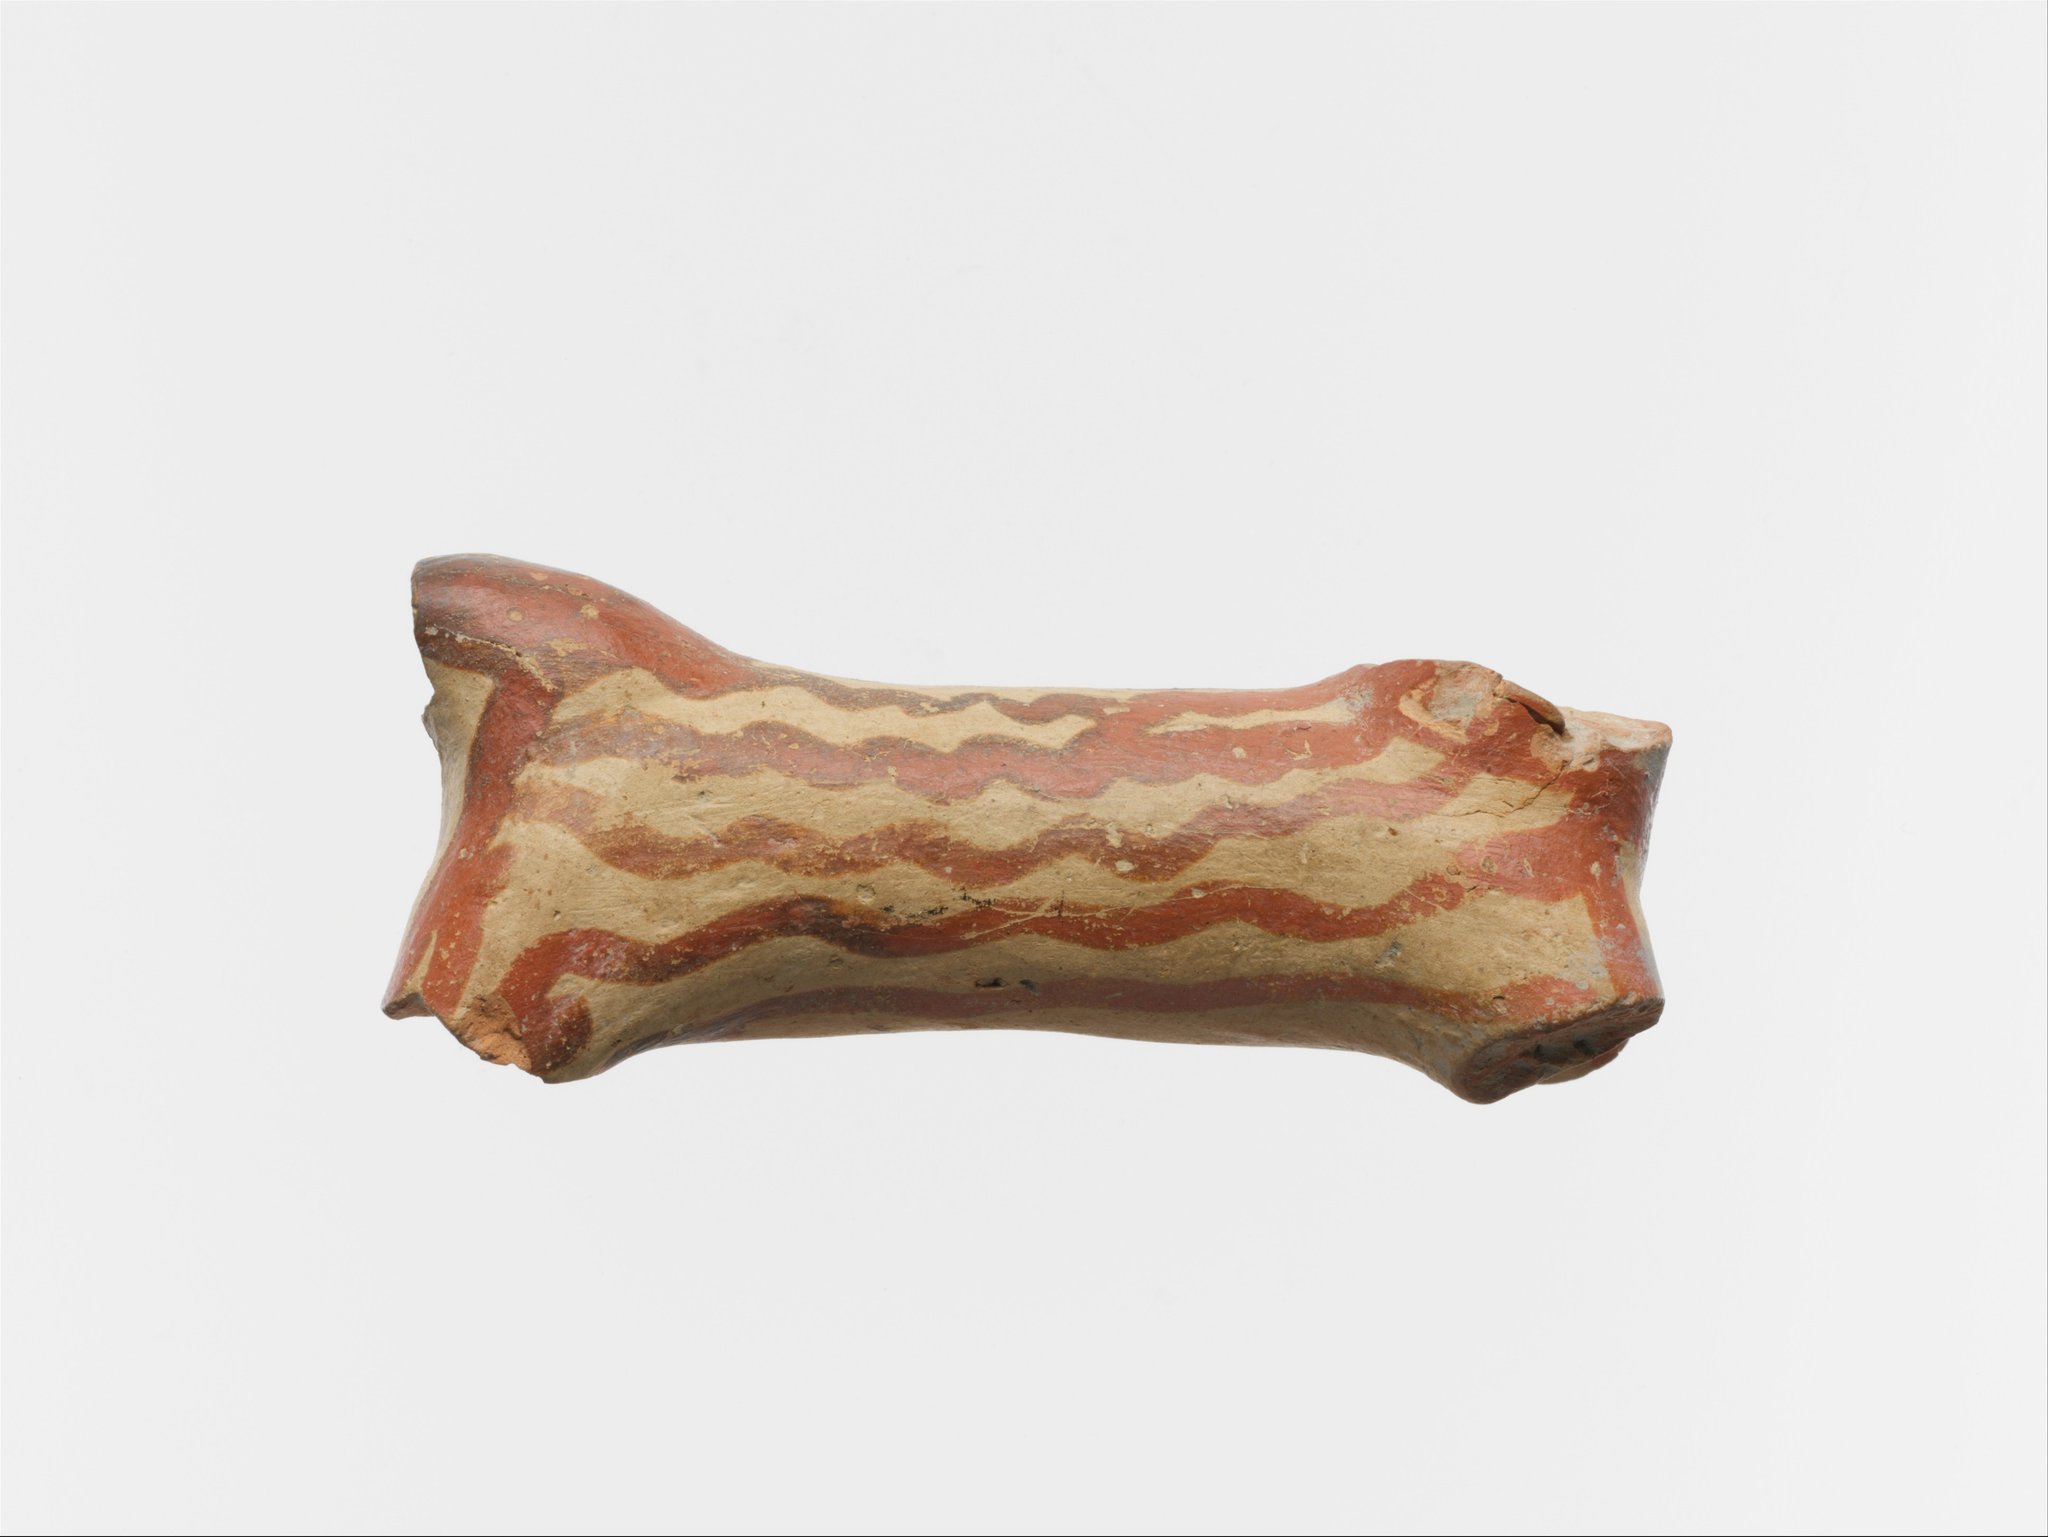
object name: statuette of a cow and calf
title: Terracotta animal figurine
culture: mycenaean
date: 1400-1201 BCE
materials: terracotta